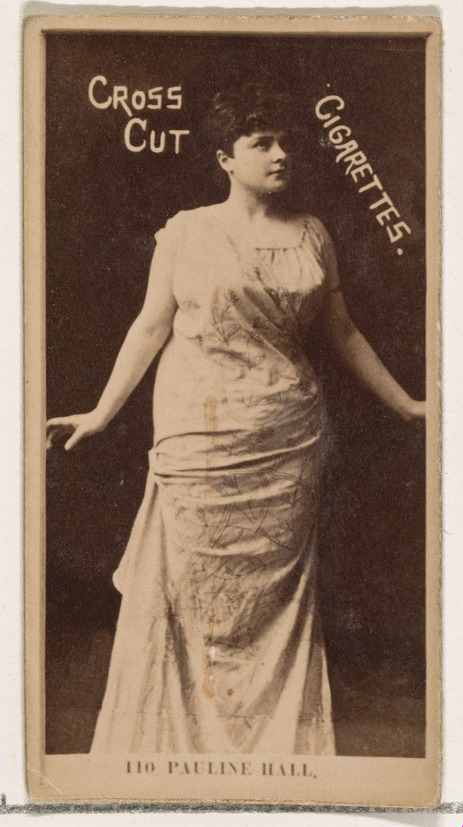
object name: print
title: Card Number 110, Pauline Hall, from the Actors and Actresses series (N145-2) issued by Duke Sons & Co. to promote Cross Cut Cigarettes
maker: w. duke, sons & co.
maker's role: publisher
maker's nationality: american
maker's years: 1870-1920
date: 1880-1889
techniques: albumen silver print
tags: portraits,women,actresses